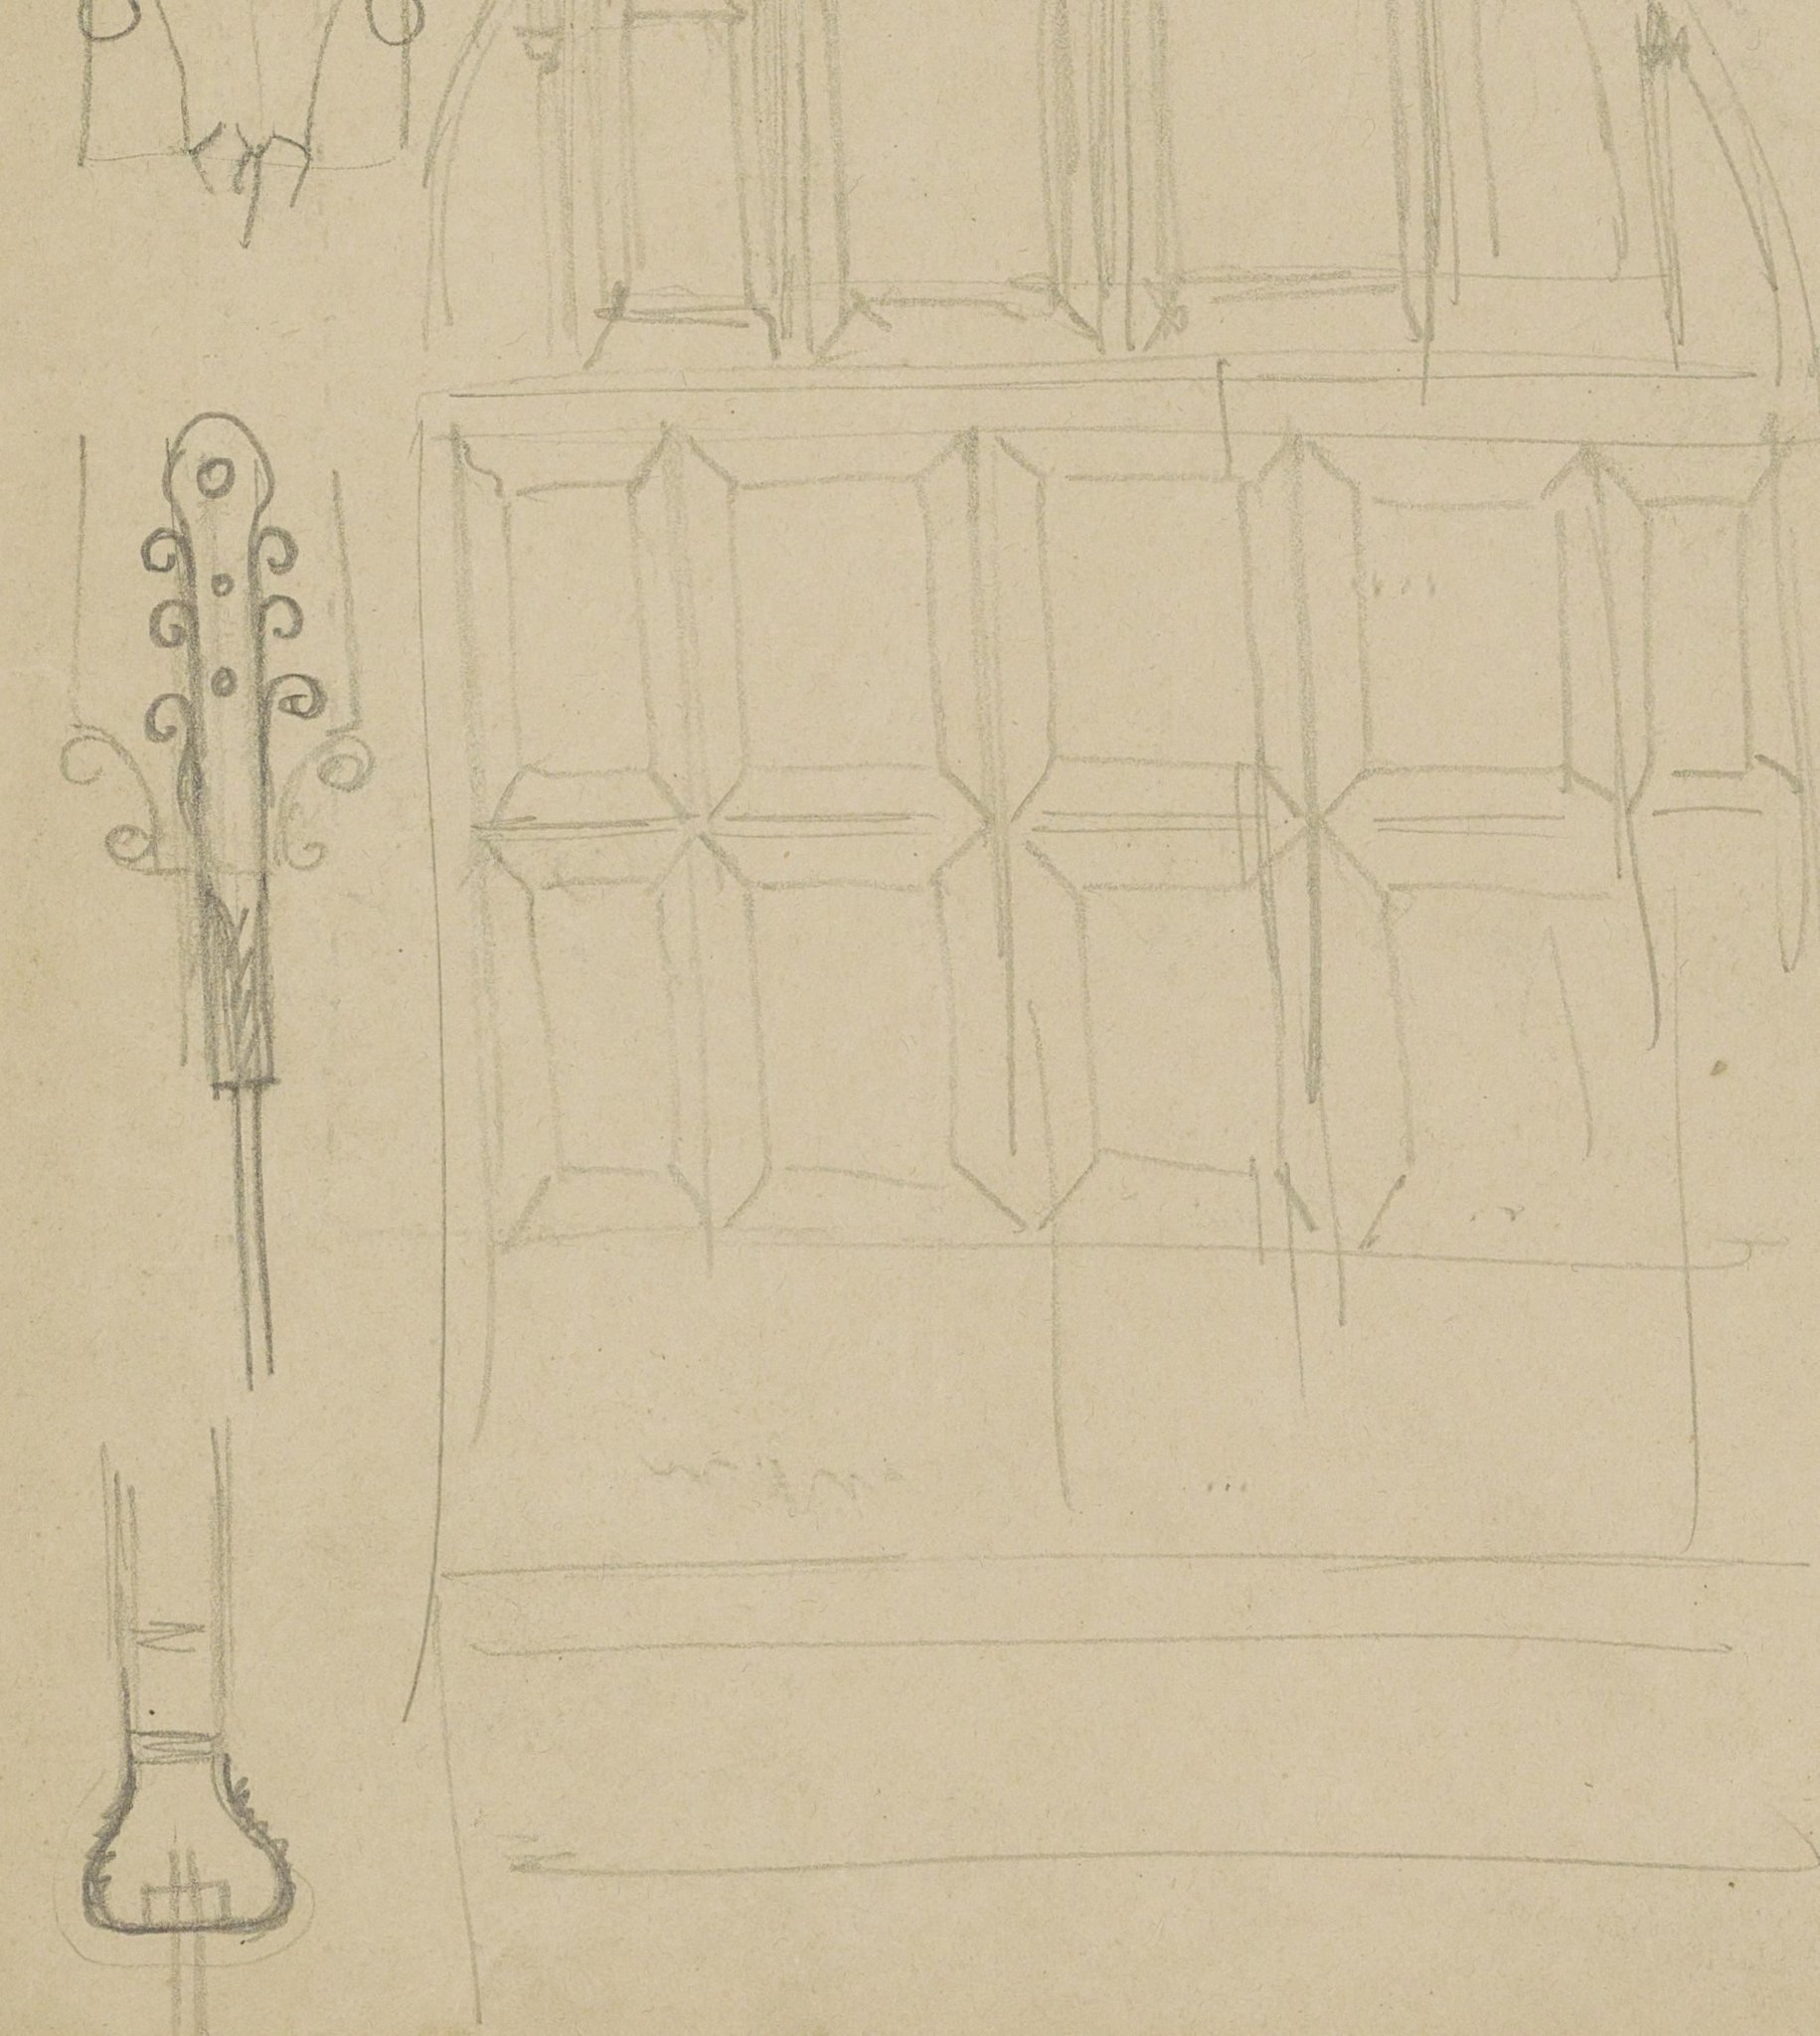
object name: sketchbook leaf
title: Kerkraam en decoratieve objecten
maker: carel adolph lion cachet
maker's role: draughtsman, print maker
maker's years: 1864-1945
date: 1905-1906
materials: paper, pencil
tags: church-window, e.g. rose-window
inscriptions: annotation: ‘[...]’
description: Blad 12 recto uit een schetsboek met 30 bladen.